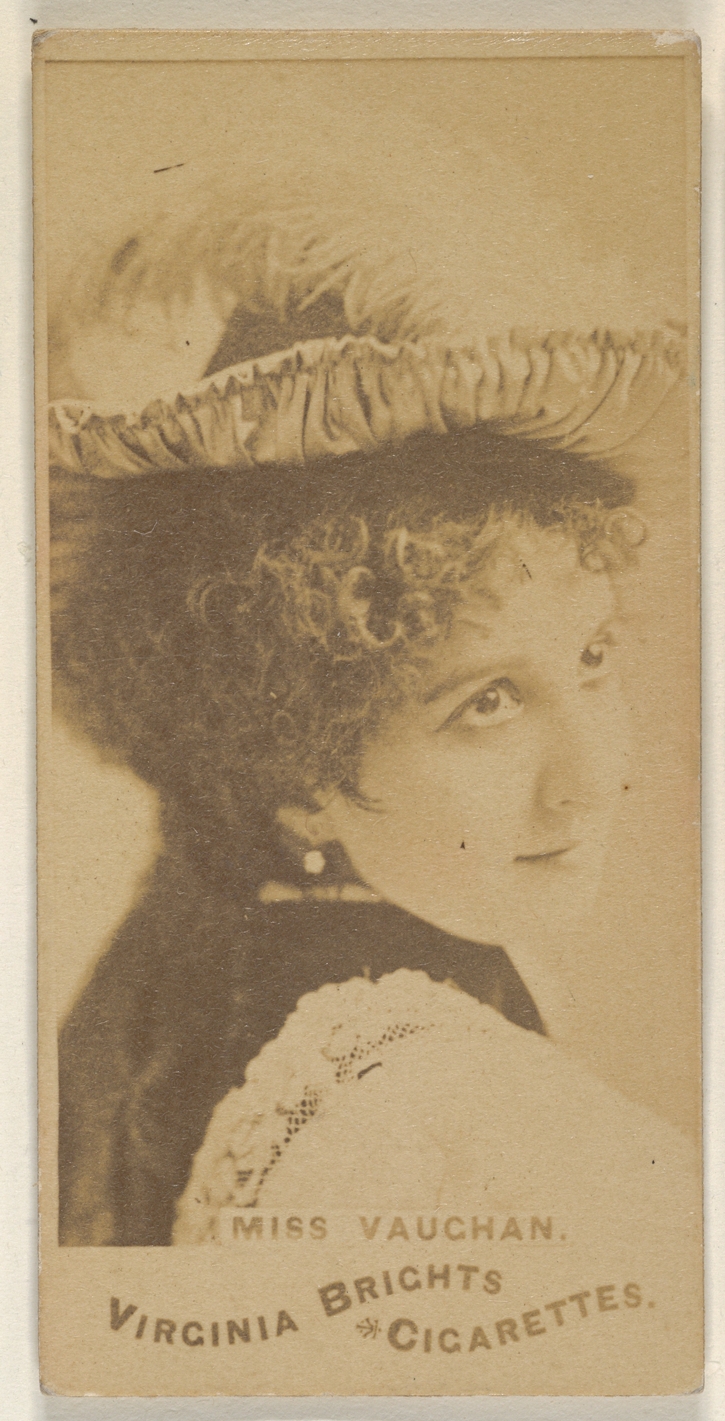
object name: photograph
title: Miss Vaughan, from the Actors and Actresses series (N45, Type 1) for Virginia Brights Cigarettes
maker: allen & ginter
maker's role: publisher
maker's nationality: american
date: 1888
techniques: albumen silver print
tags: portraits,women,actresses